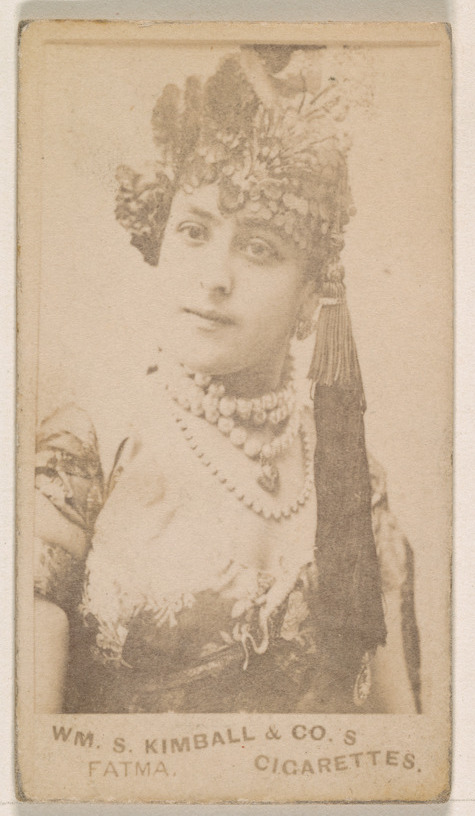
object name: photograph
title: Miss Fatma, from the Actresses series (N203) issued by Wm. S. Kimball & Co.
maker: william s. kimball & company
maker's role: publisher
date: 1889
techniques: color lithograph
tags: portraits,women,actresses